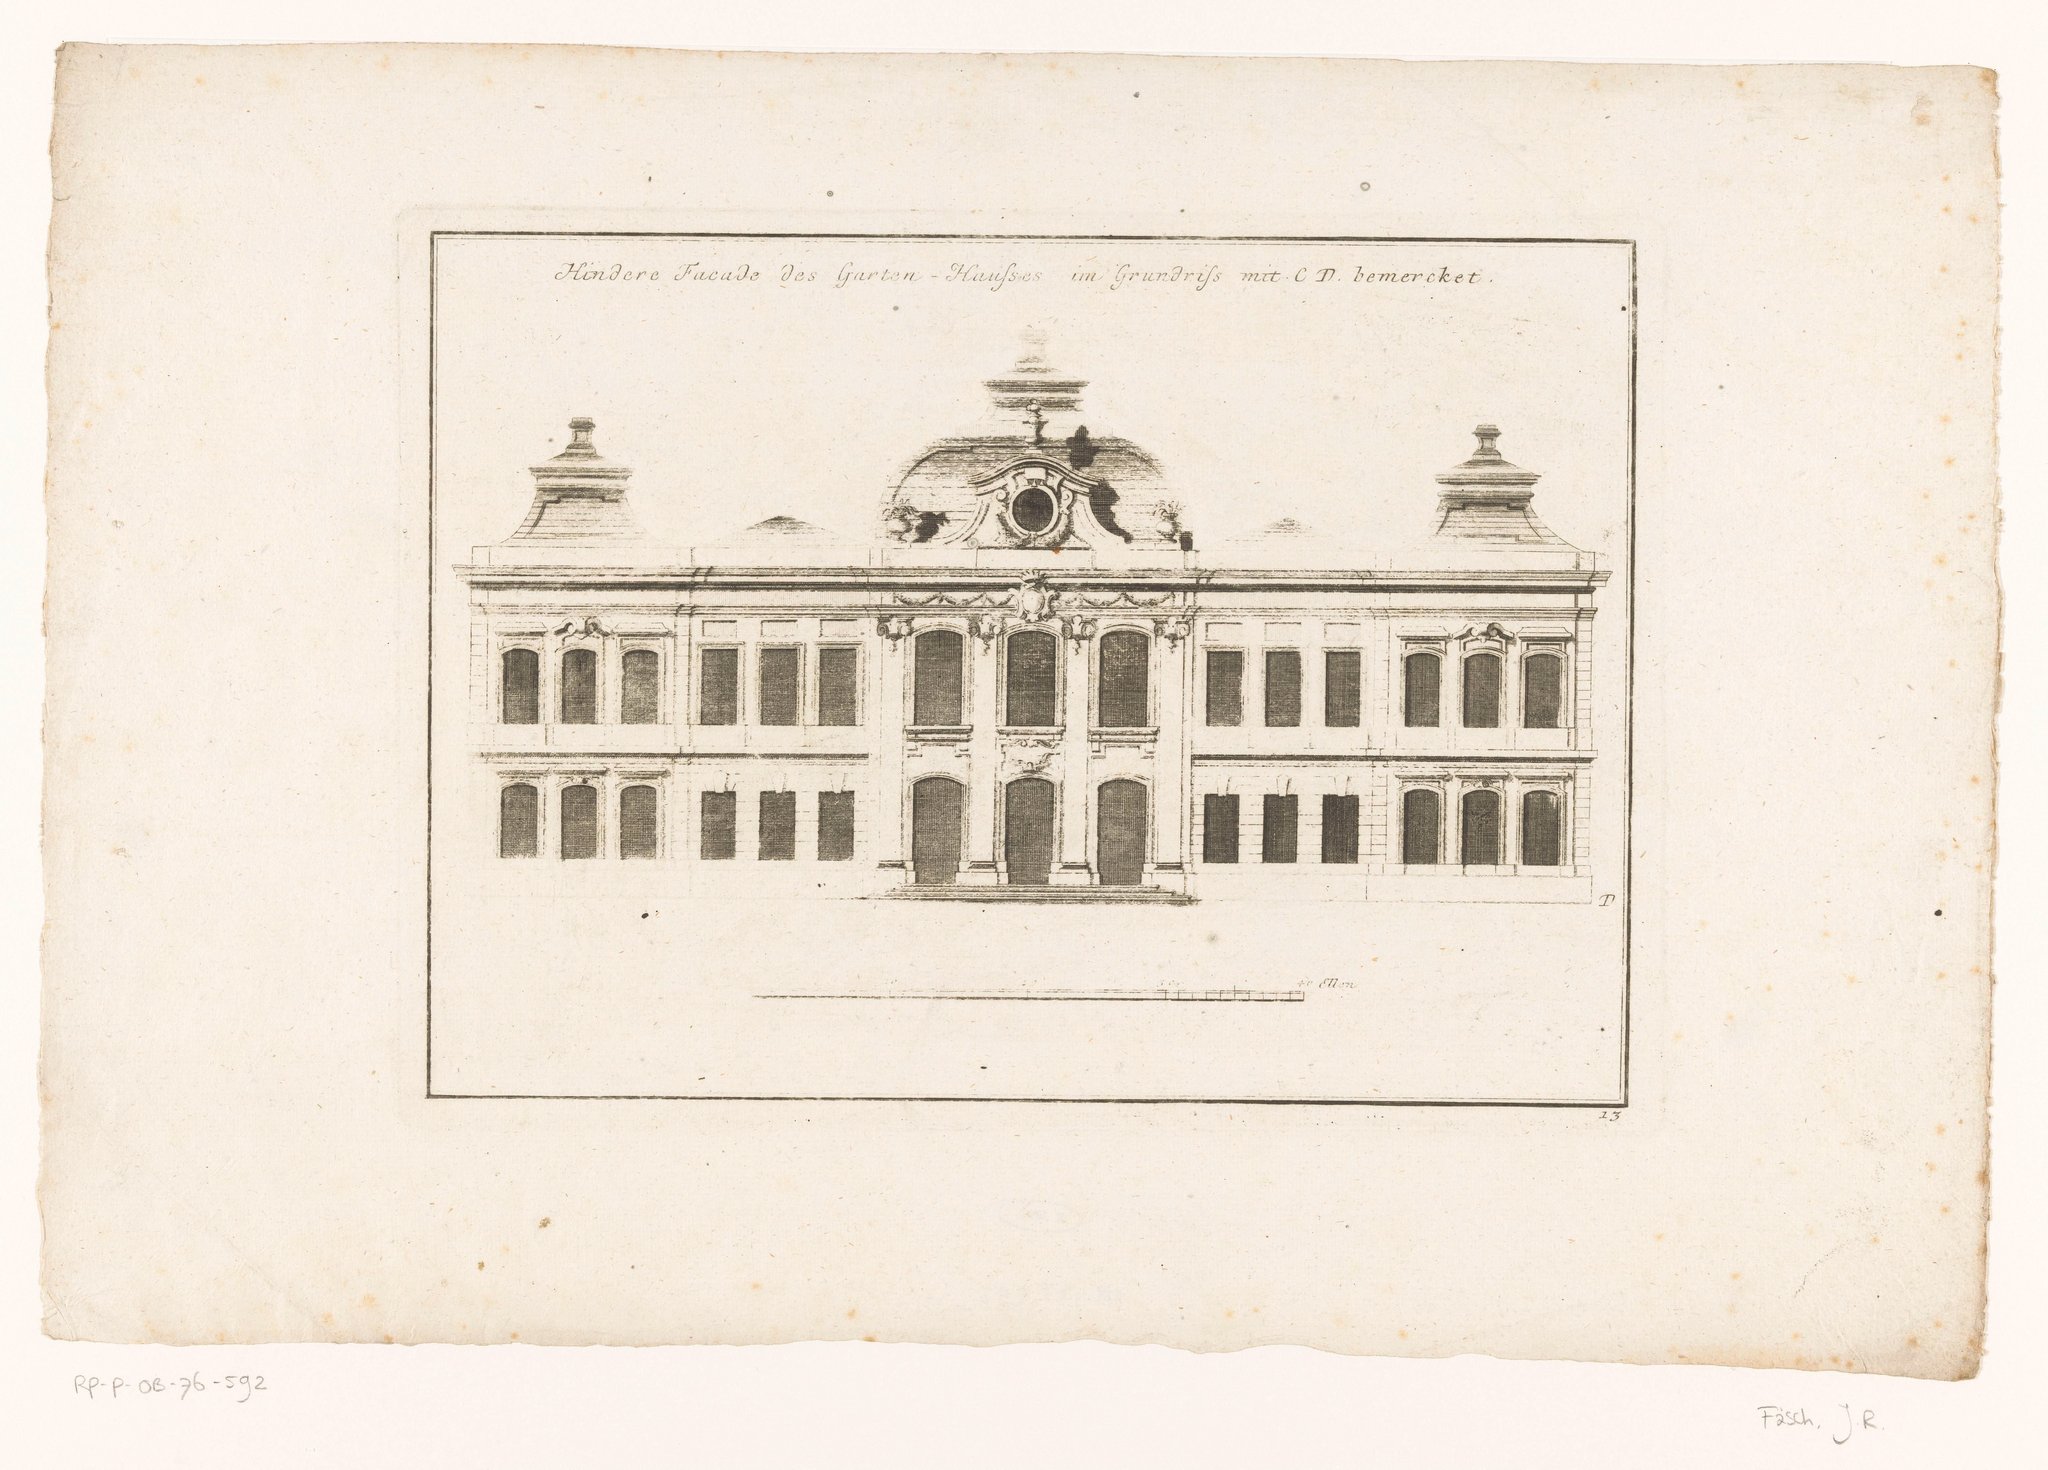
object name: print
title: Hindere Facade des Garten-Hausses im Grundriss mit C D. bemercket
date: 1729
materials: paper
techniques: engraving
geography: nuremberg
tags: rear façade, summer-house, arbour, garden-house (dutch: 'theekoepel')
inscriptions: collector's mark: Lugt 2228